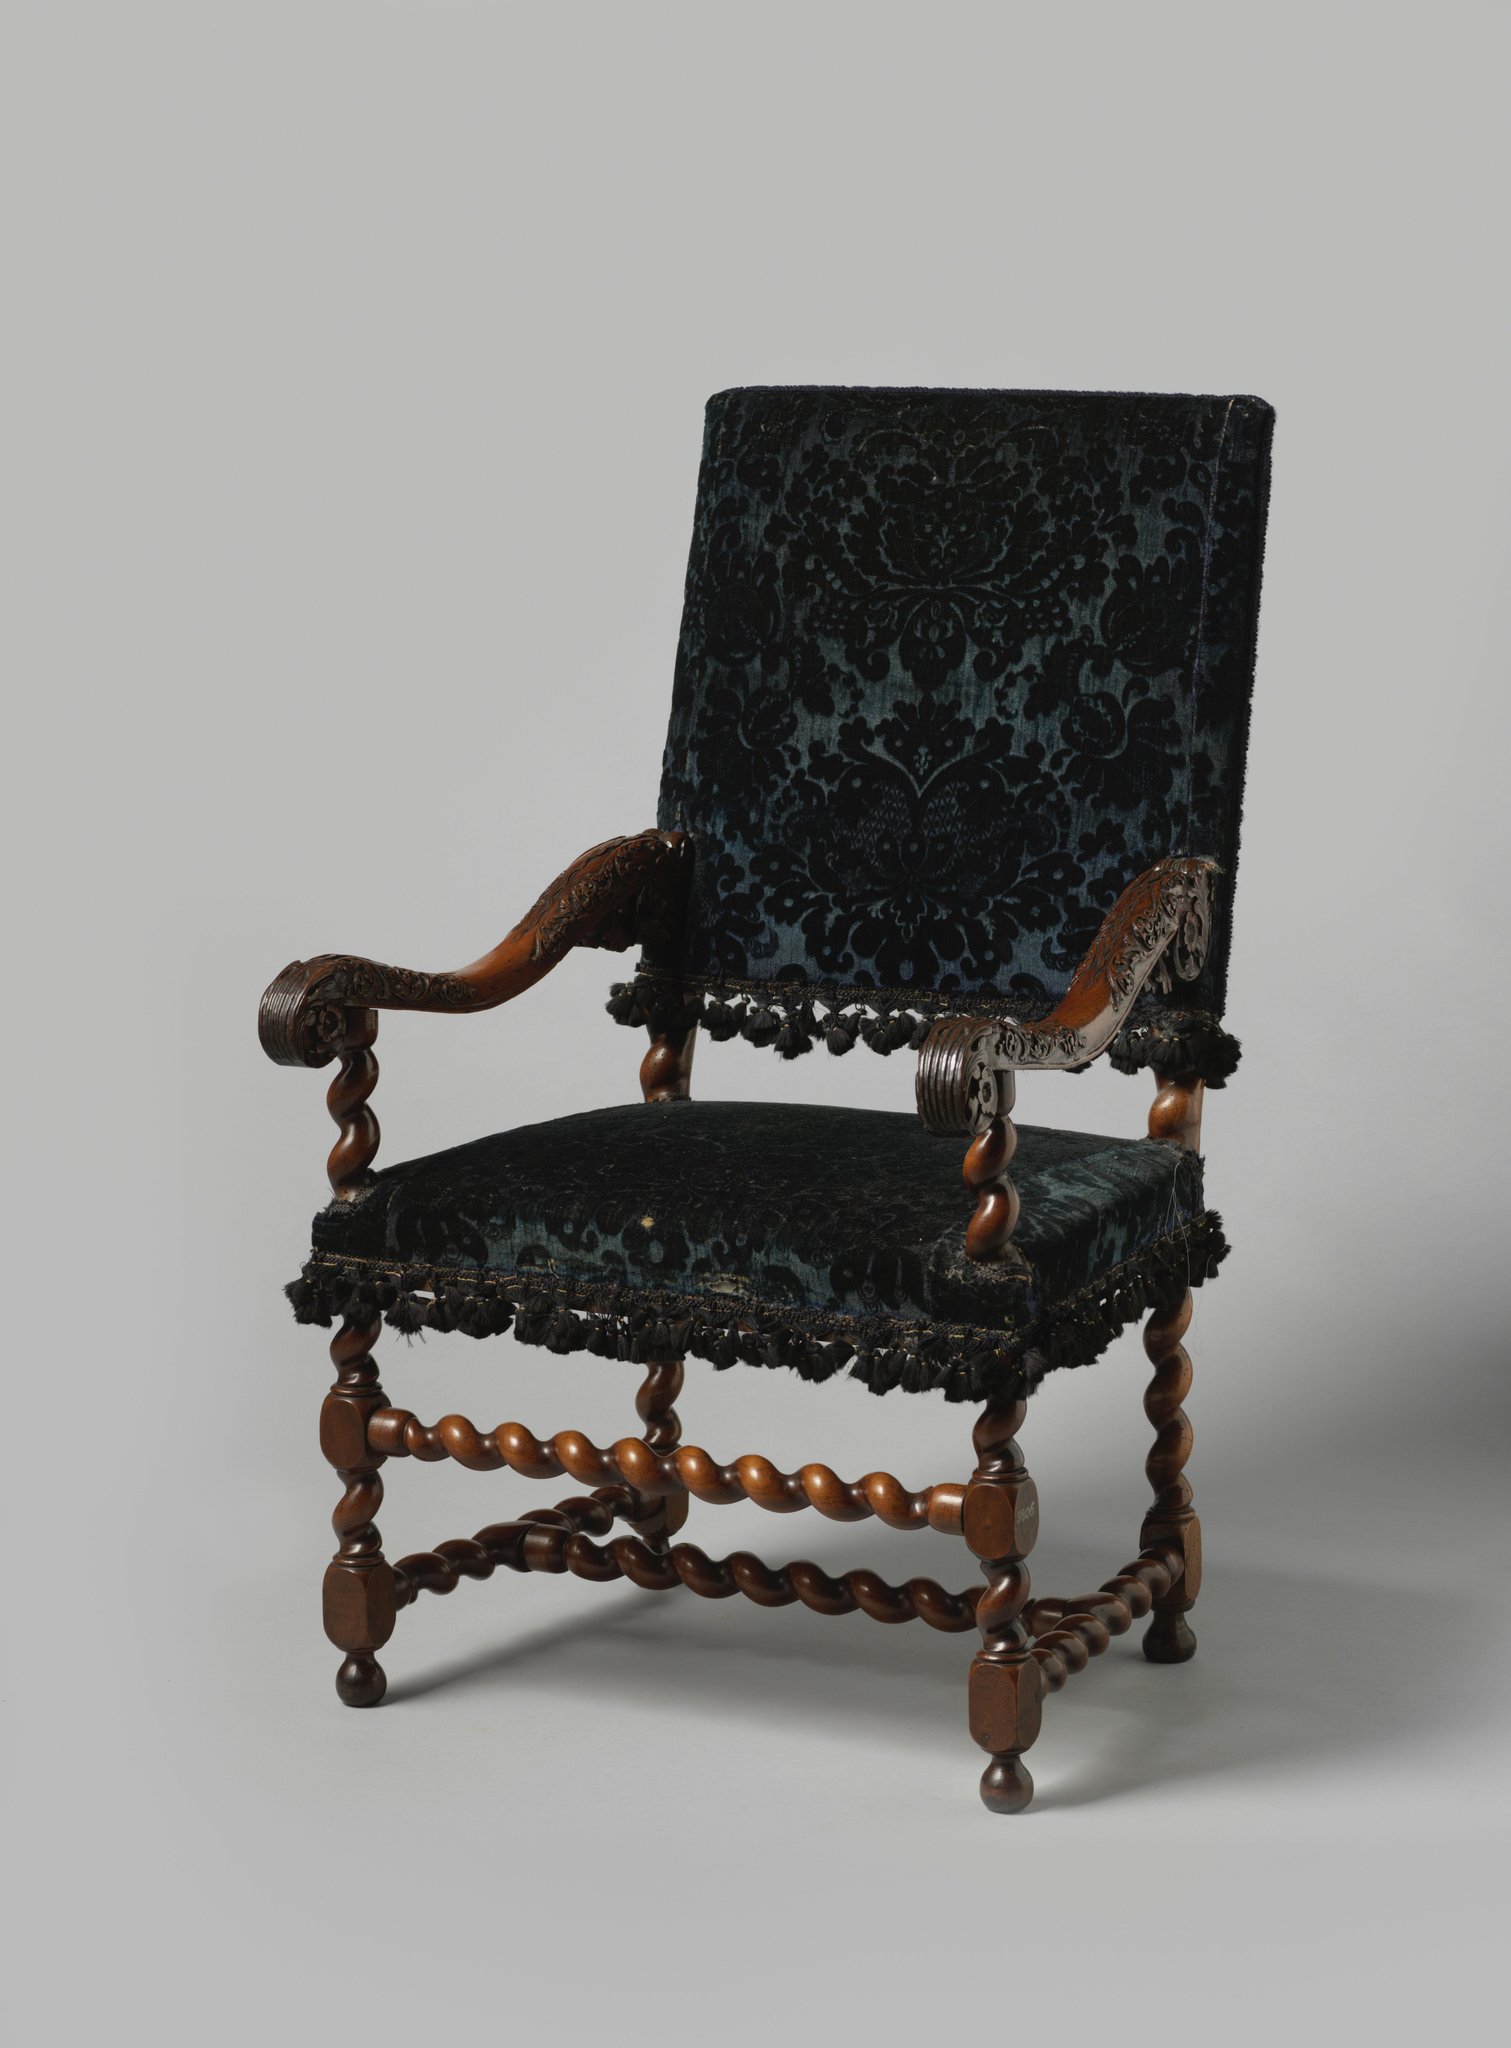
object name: seating furniture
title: Armstoel met geslingerde poten, bekleed met zwarte, geciseleerde fluweel met een patroon van symmetrische verbasterde granaatmotieven en acanthusbladeren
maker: Anonymous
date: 1675-1700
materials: velvet, wood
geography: northern netherlands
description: Armstoel van notenhout, bekleed met zwarte, geciseleerde fluweel. Het meubel heeft geslingerde poten, door een H-vormig kruis en een voorsport verbonden. De armleggers rusten op geslingerde armleggerstutten, zijn gehold en eindigen in een voluut, die evenals het achterpand met een acanthusblad versierd is. Het patroon van de bekleding bestaat uit symmetrische verbasterde granaatmotieven en acanthusbladeren. De franje is zwart, doorwerkt met smalle gele biezen en versierd met kwastjes.